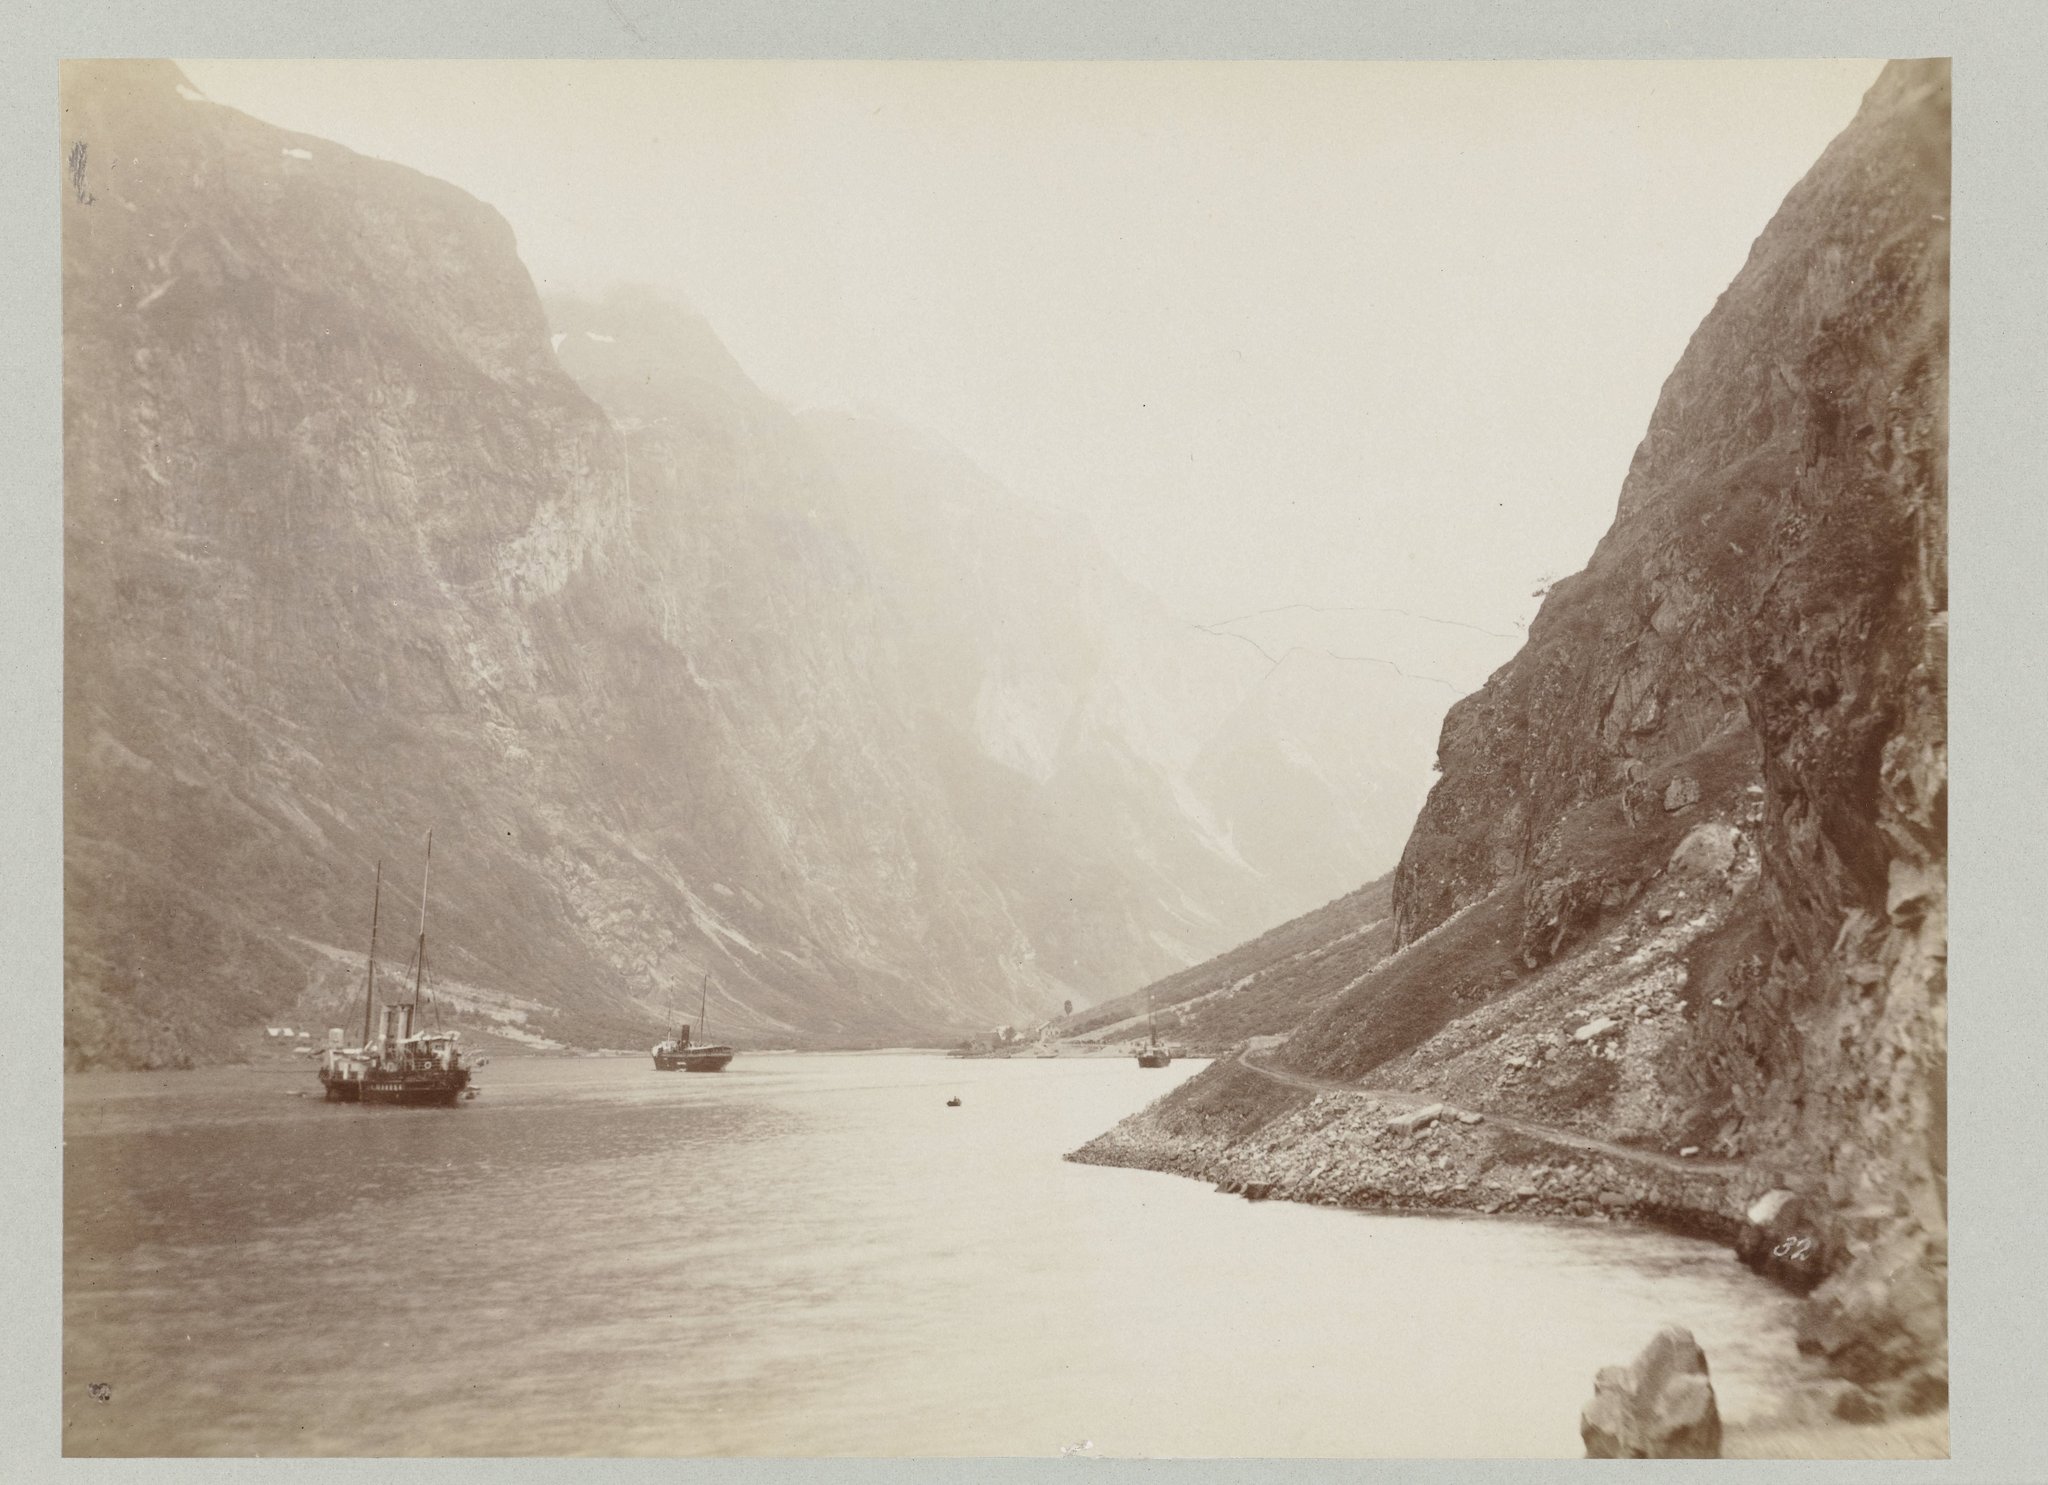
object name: photograph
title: Schip op een rivier in het bergachtige Noorse landschap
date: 1807-1889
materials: cardboard, paper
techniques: albumen print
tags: wilhelm ii (keizer van duitsland), norway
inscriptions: number: ‘15a’, number: ‘32’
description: De afdruk van de foto is rond, het papier vierkant